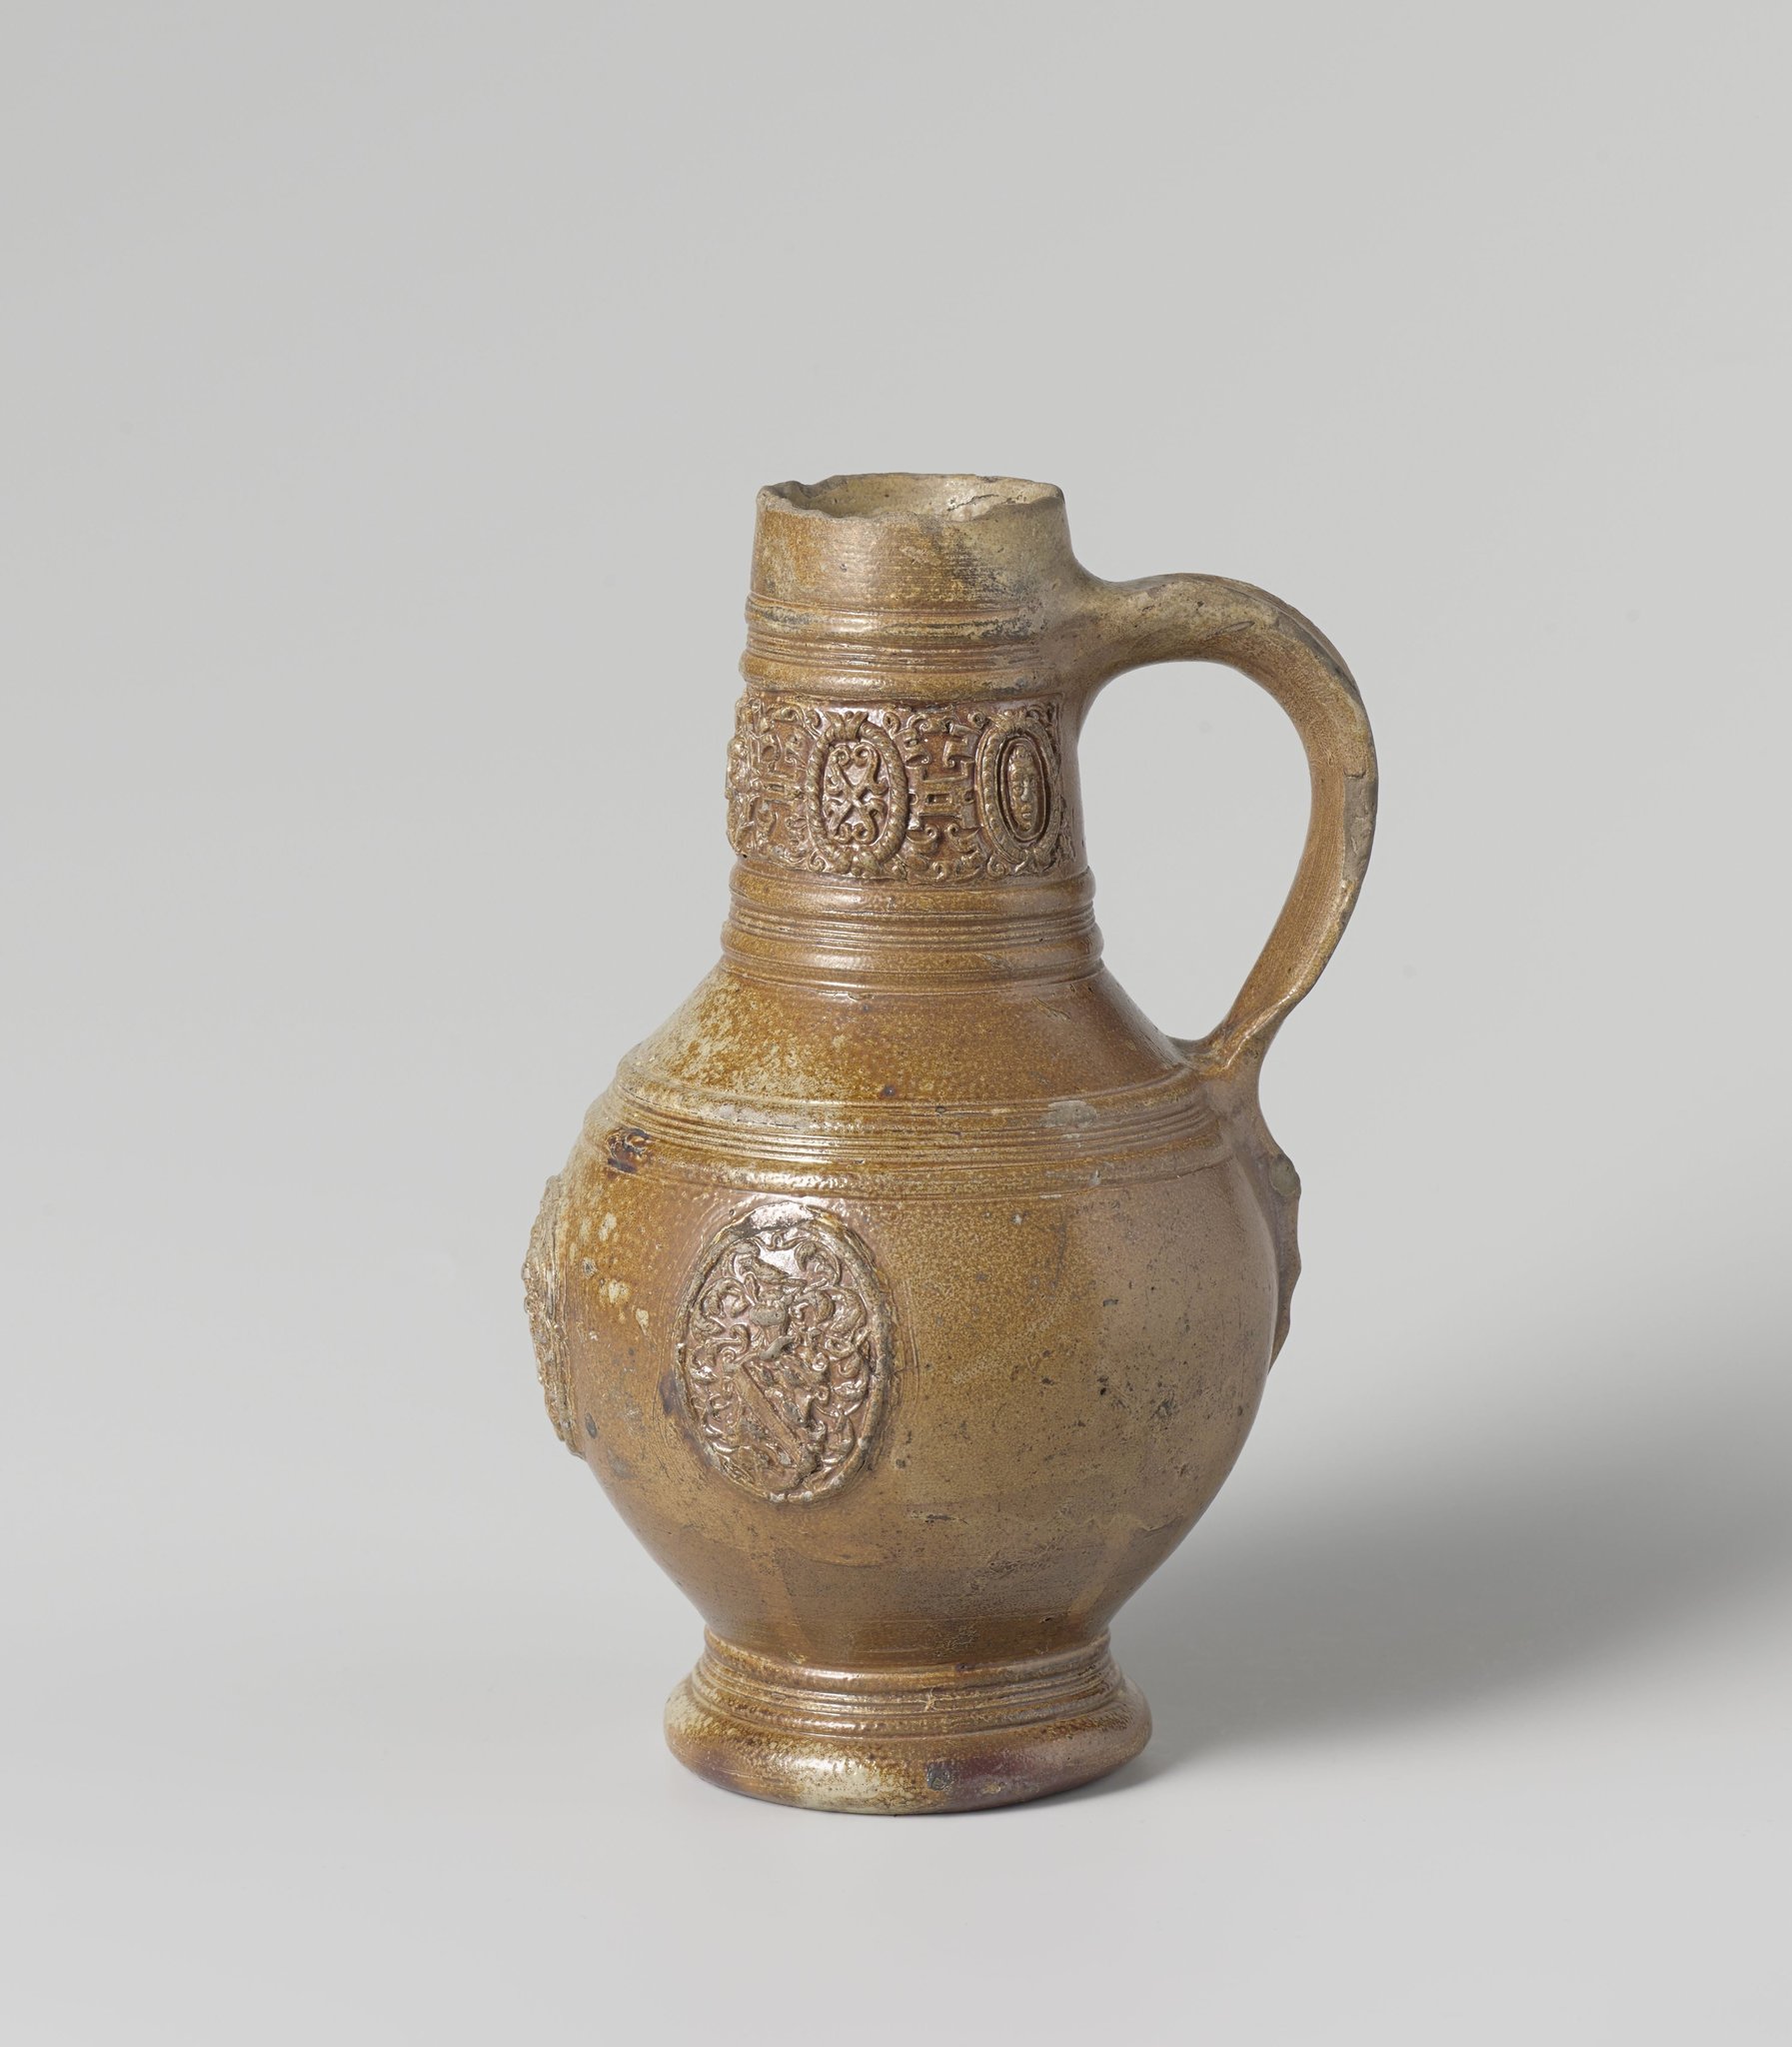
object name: jug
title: Jug with a coat of arms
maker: Anonymous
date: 1550-1599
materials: engobe, glaze, stoneware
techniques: firing, forming, relief, turning, vitrification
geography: raeren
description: Kruik van steengoed op hoge voet met een bolvormig lichaam en lange, smalle nek. Het C-vormige oor is bevestigd aan de nek en de schouder. Profielen op de nek, schouder en voet. Bedekt met een bruine engobe. Op de buik in reliëf driemaal een gedrukt en opgelegde medaillon met een wapen omringd door bladranken. Op de nek een band van aaneengeschakelde medaillons met maskers en omgeven door bladranken. Raeren.